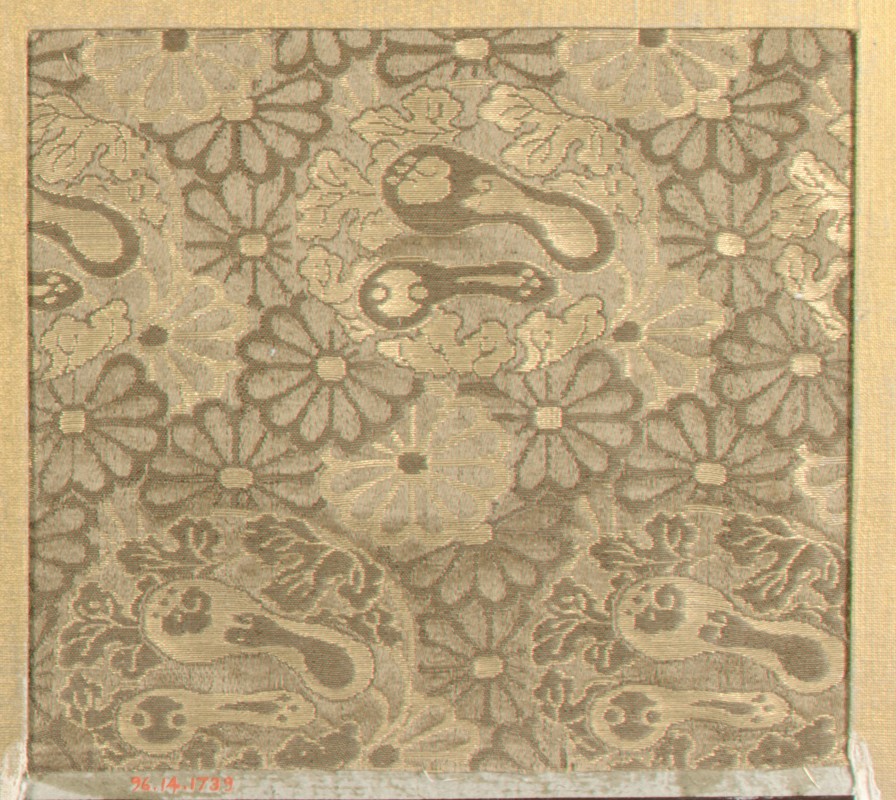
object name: piece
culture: japanese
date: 1701-1900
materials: silk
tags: flowers,gourds